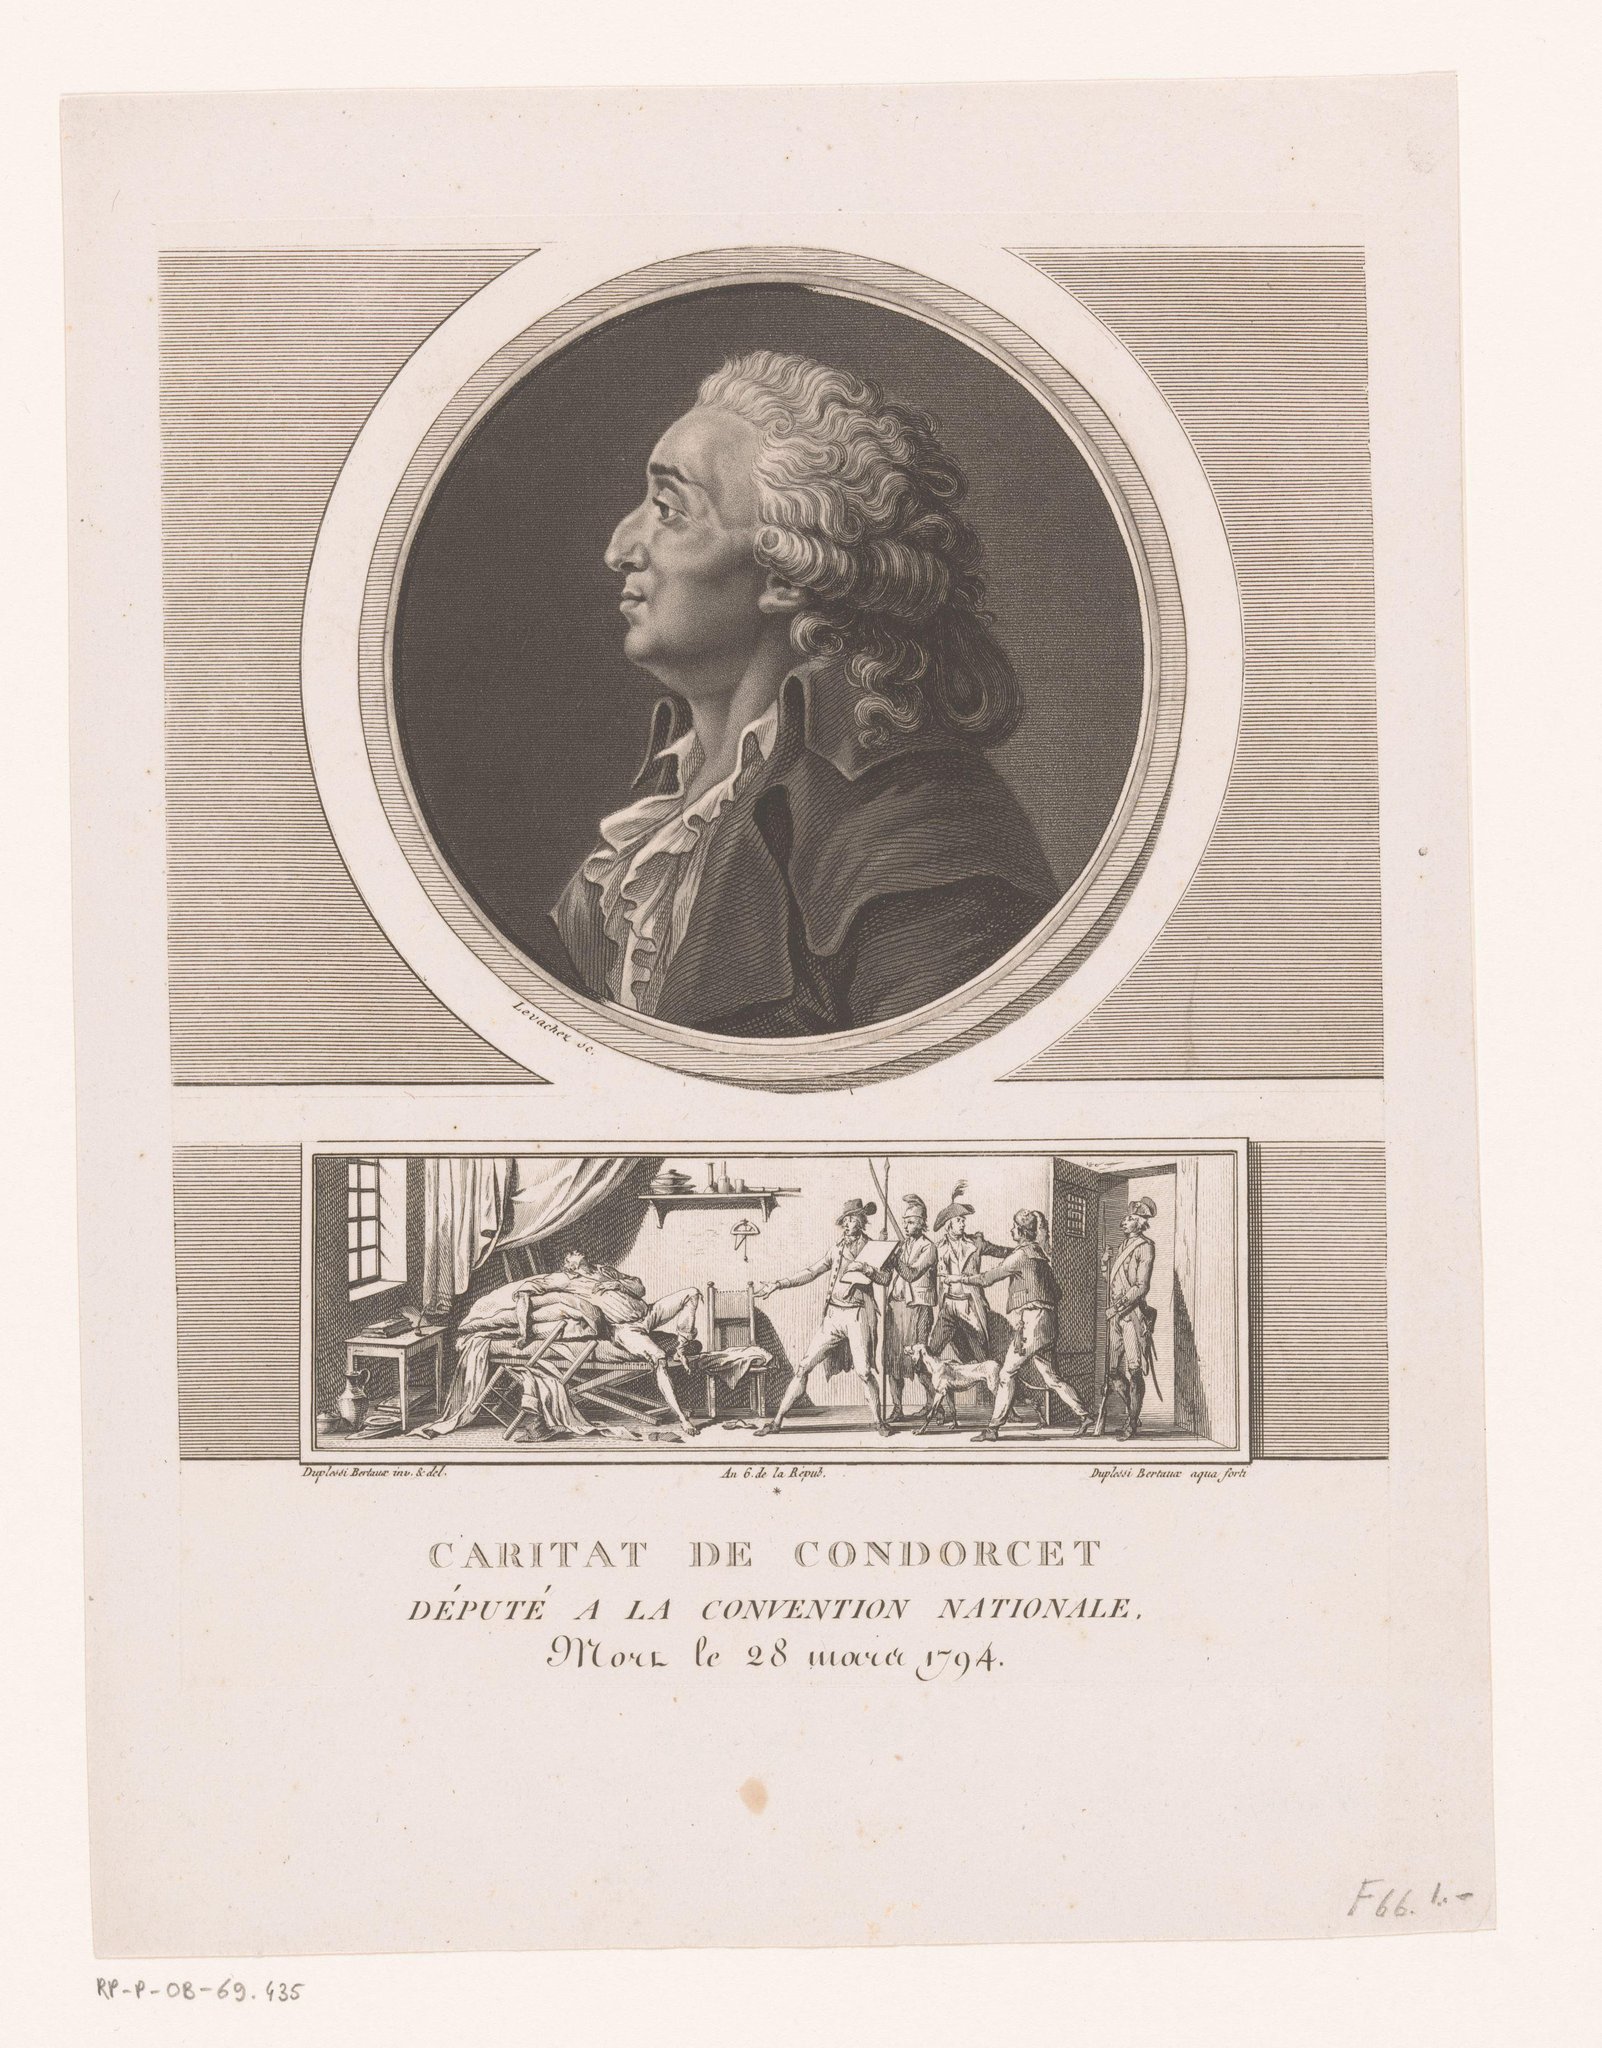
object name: print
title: Portret van Nicolas de Condorcet boven de dood van Condorcet in de gevangenis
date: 1794-1818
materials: paper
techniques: aquatint, etching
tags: politician, prison, jail, historical persons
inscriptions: collector's mark: Lugt 2228